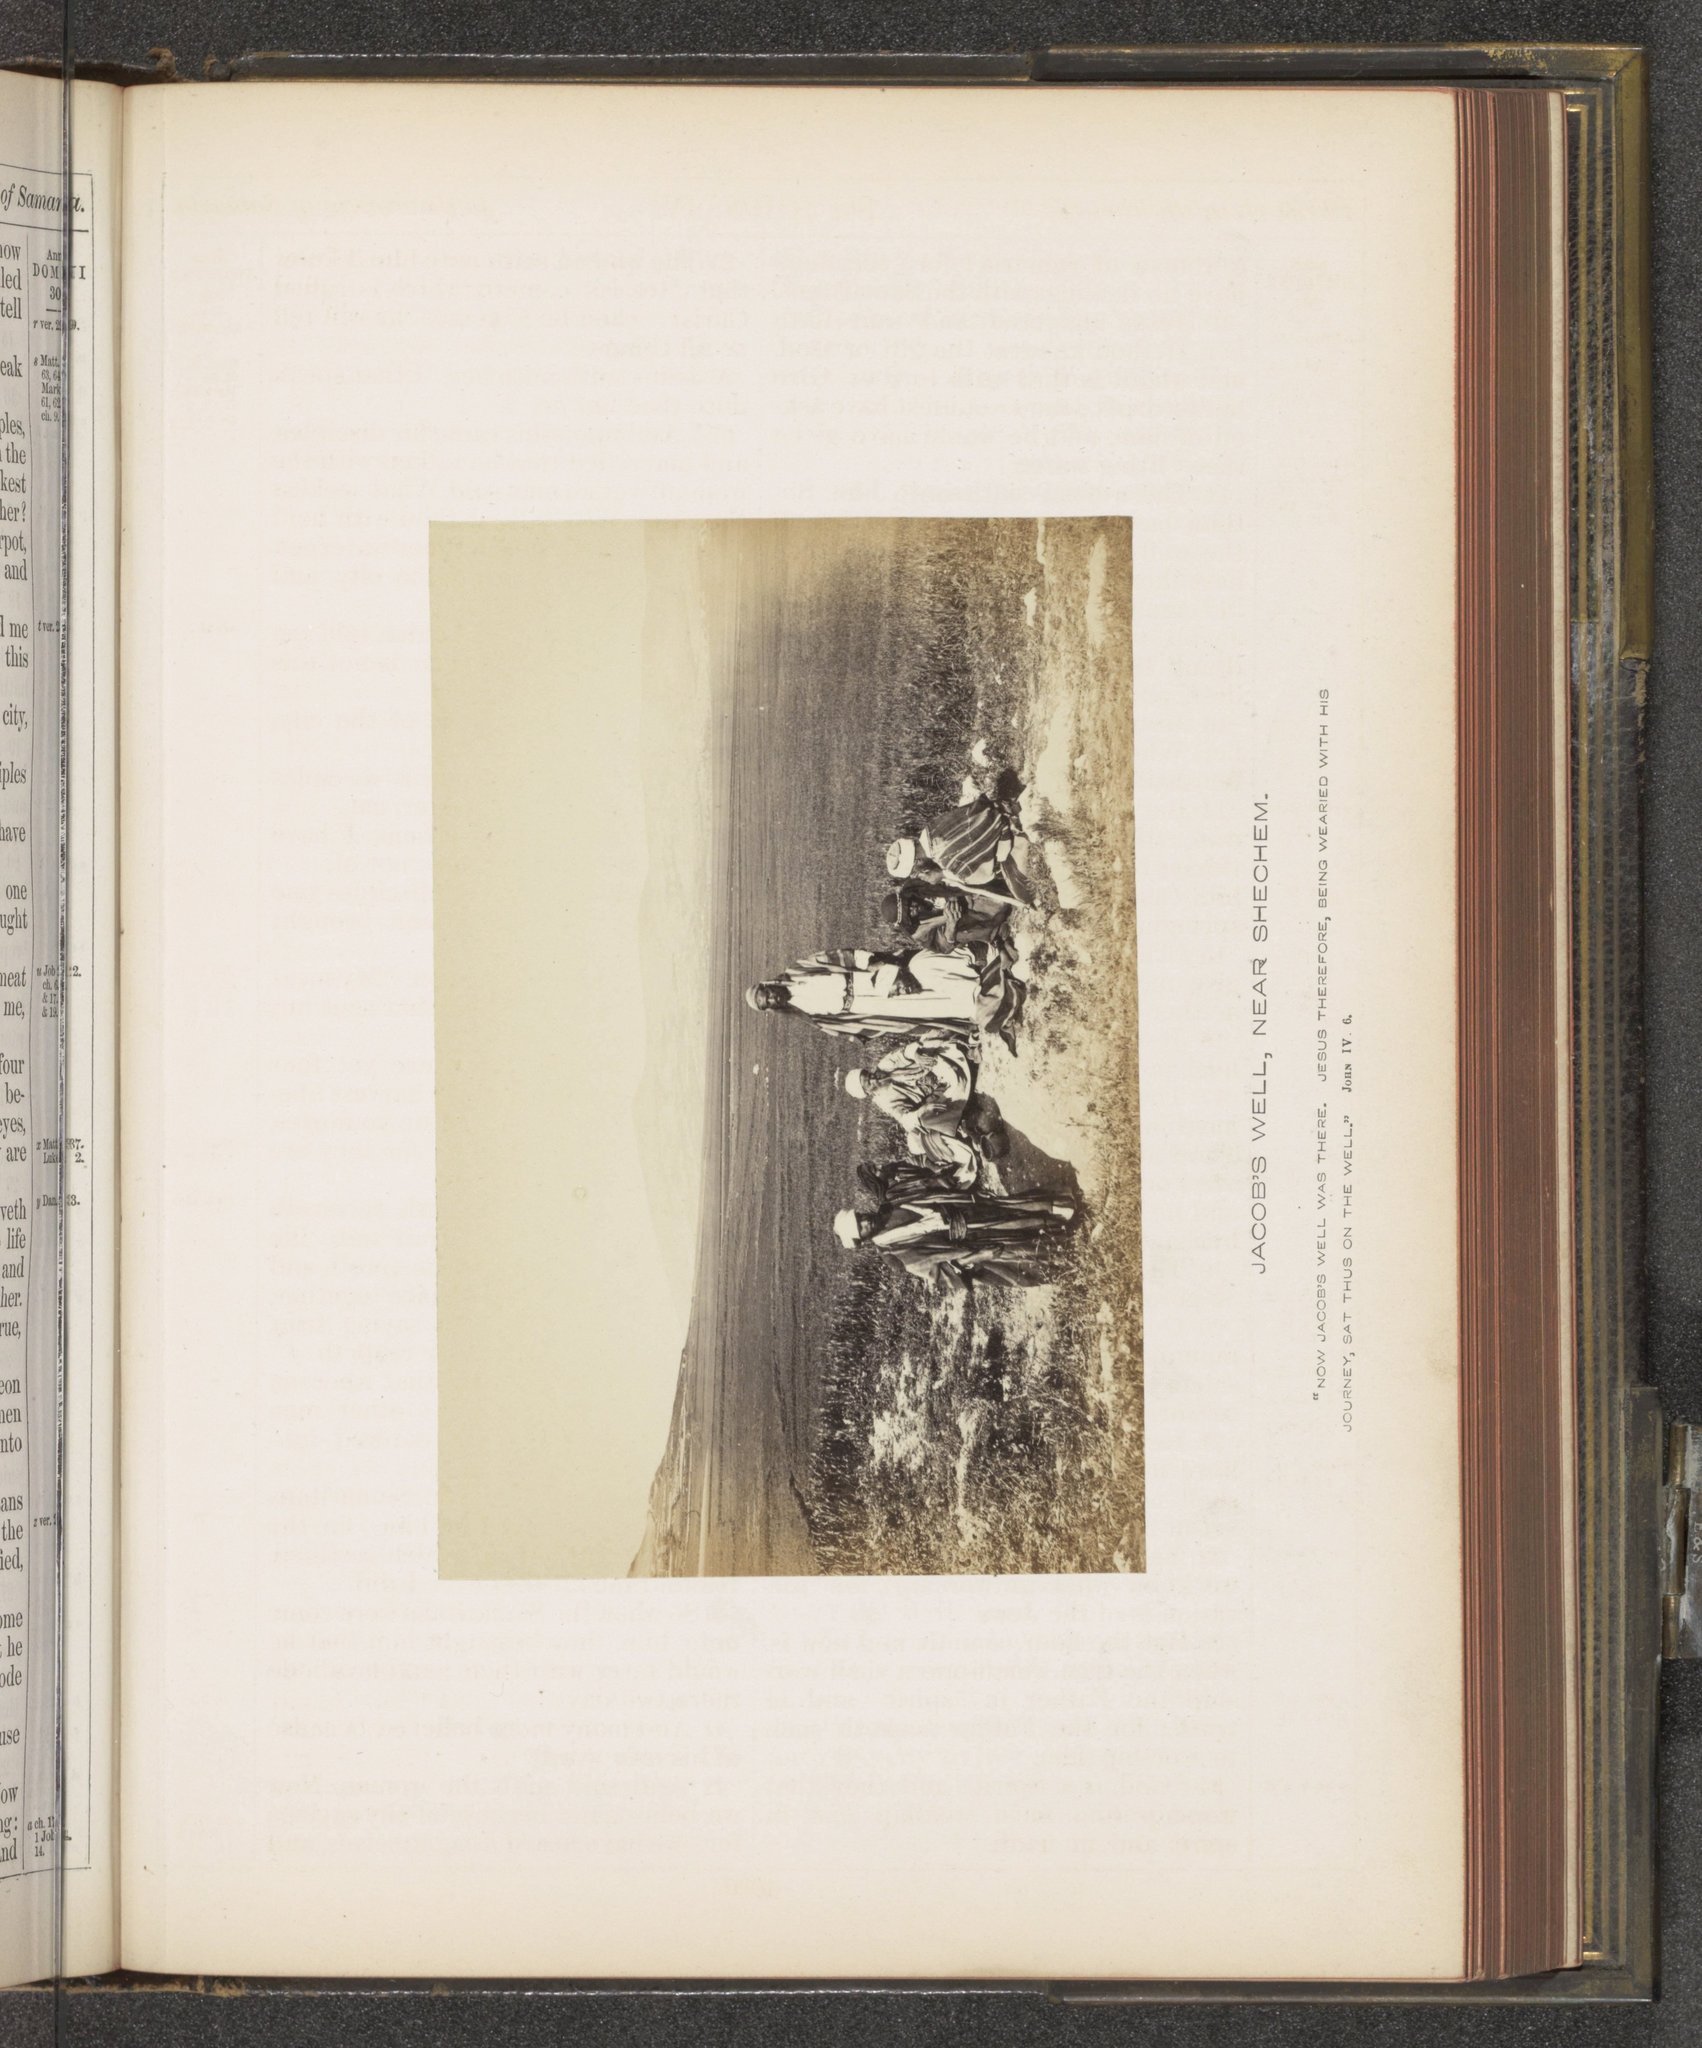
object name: photograph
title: Jacob's Well, Near Shechem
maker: francis frith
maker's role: publisher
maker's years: 1822-1898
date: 1850-1865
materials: photographic support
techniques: albumen print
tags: landscapes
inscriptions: inscription: ‘"Now Jacob's well was there, Jesus therefore, being wearied with his journey, sat thus on the well."John IV. 6.’